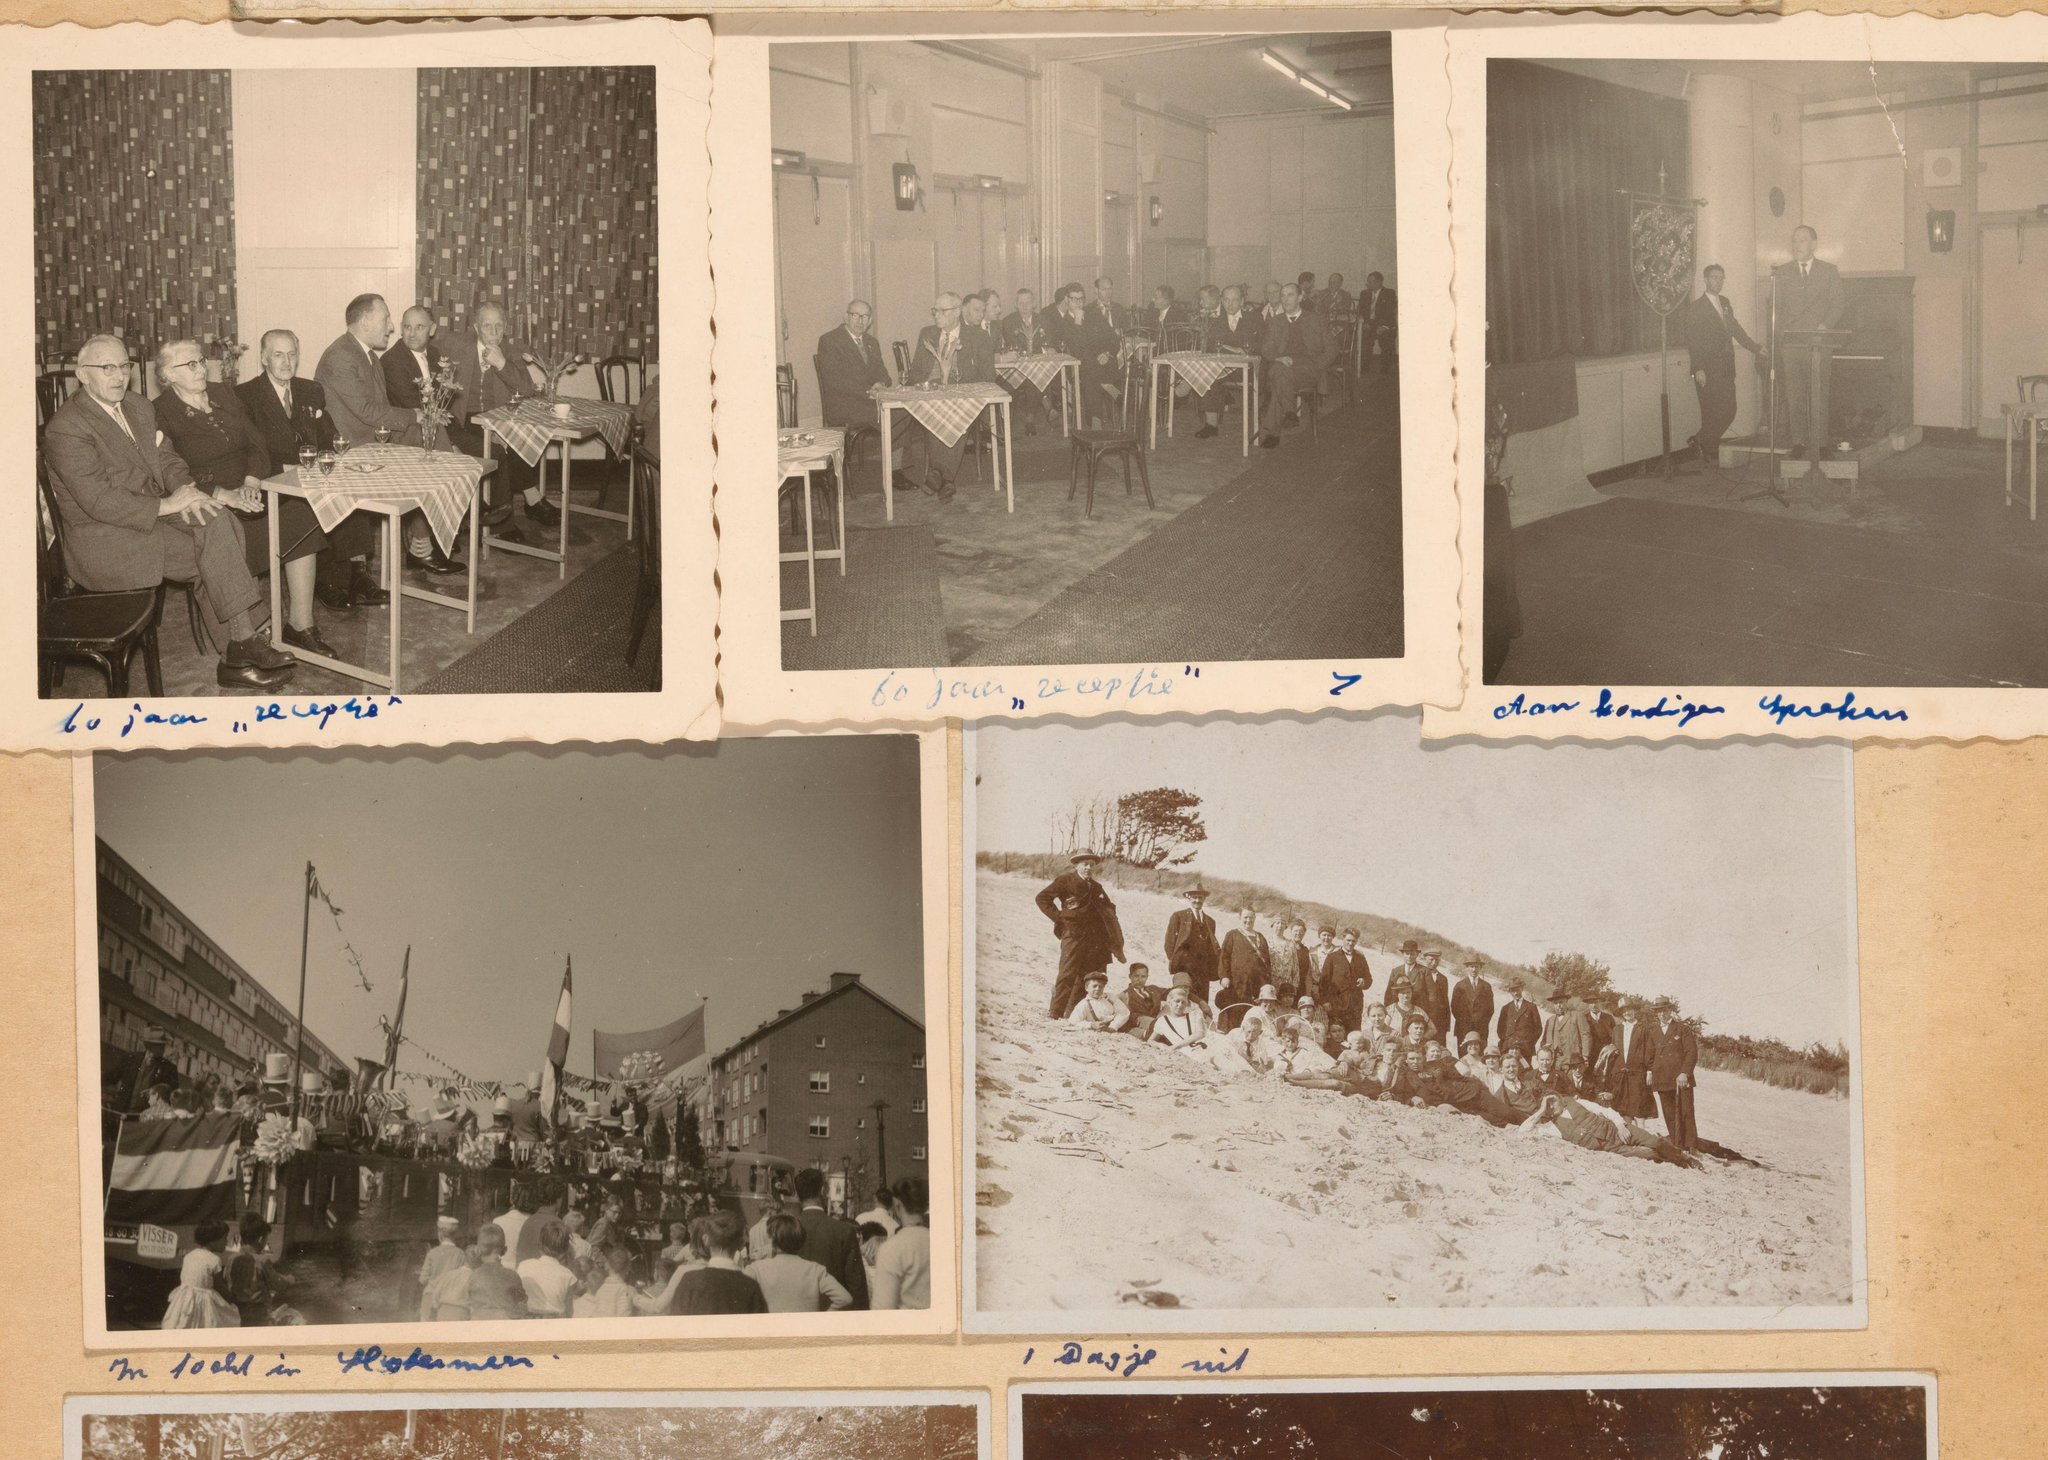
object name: photograph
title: aankondiging spreker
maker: Anonymous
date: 1950-1970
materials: cardboard, photographic support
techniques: gelatin silver print